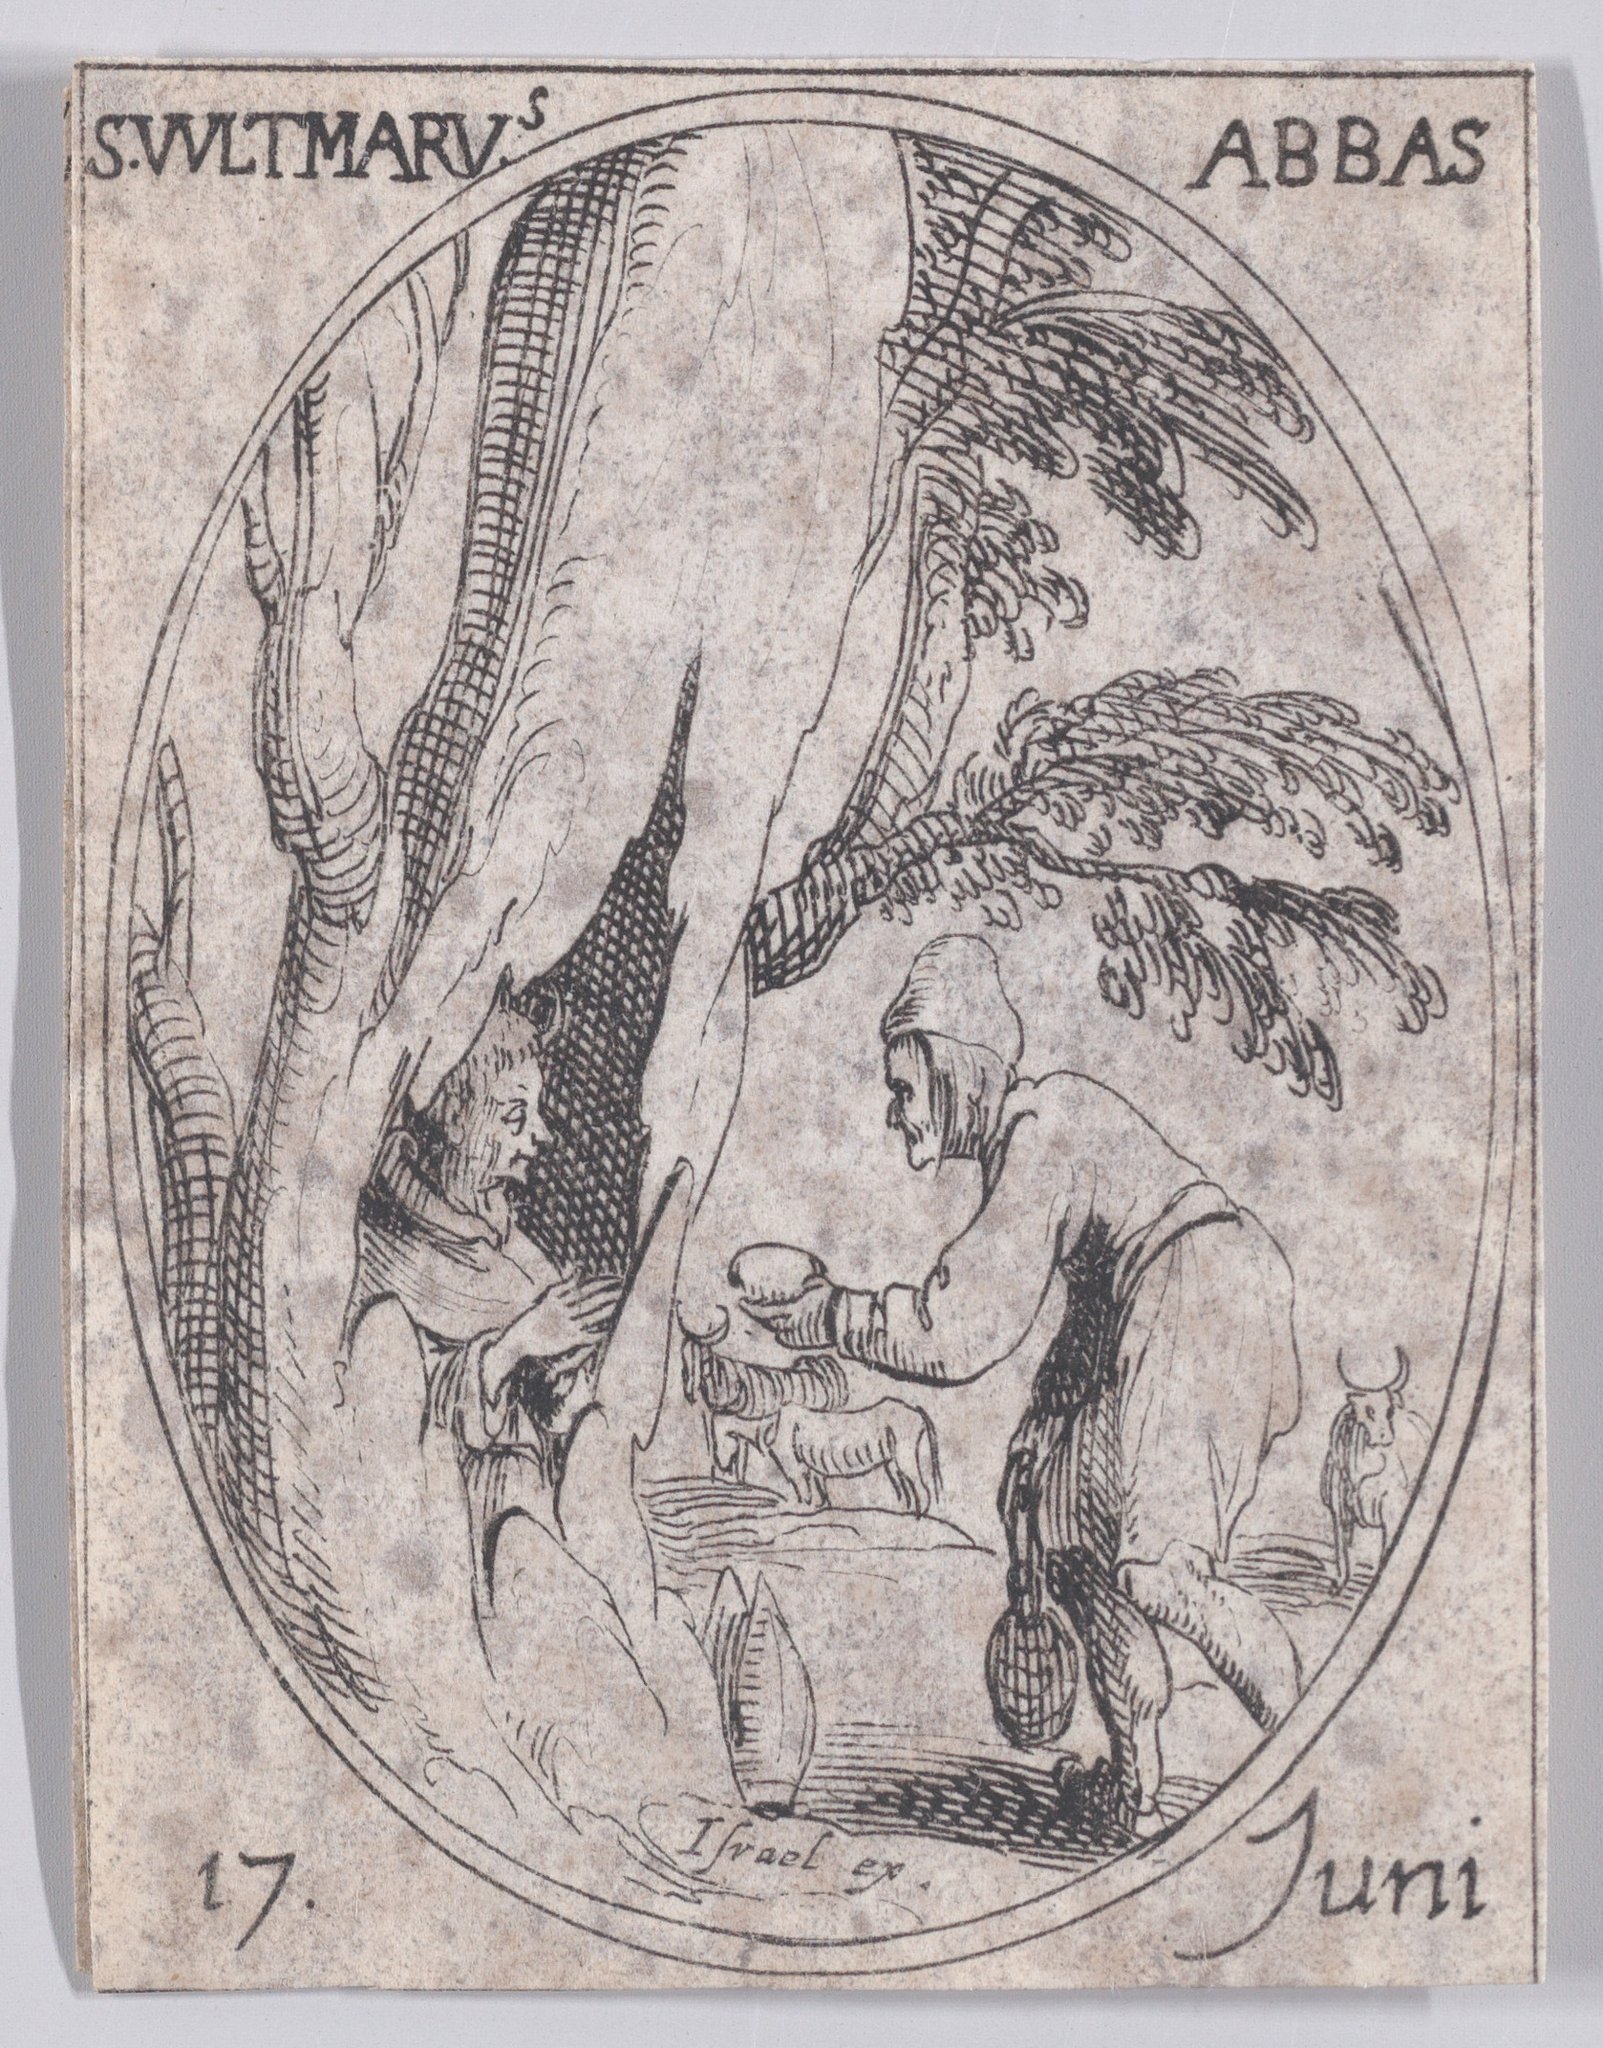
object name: print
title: S. Vultmar, abbé (St. Vultmar, Abbot), June 17th, from "Les Images De Tous Les Saincts et Saintes de L'Année" (Images of All of the Saints and Religious Events of the Year)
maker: jacques callot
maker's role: artist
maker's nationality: french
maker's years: 1592-1635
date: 1636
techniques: etching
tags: men,saints